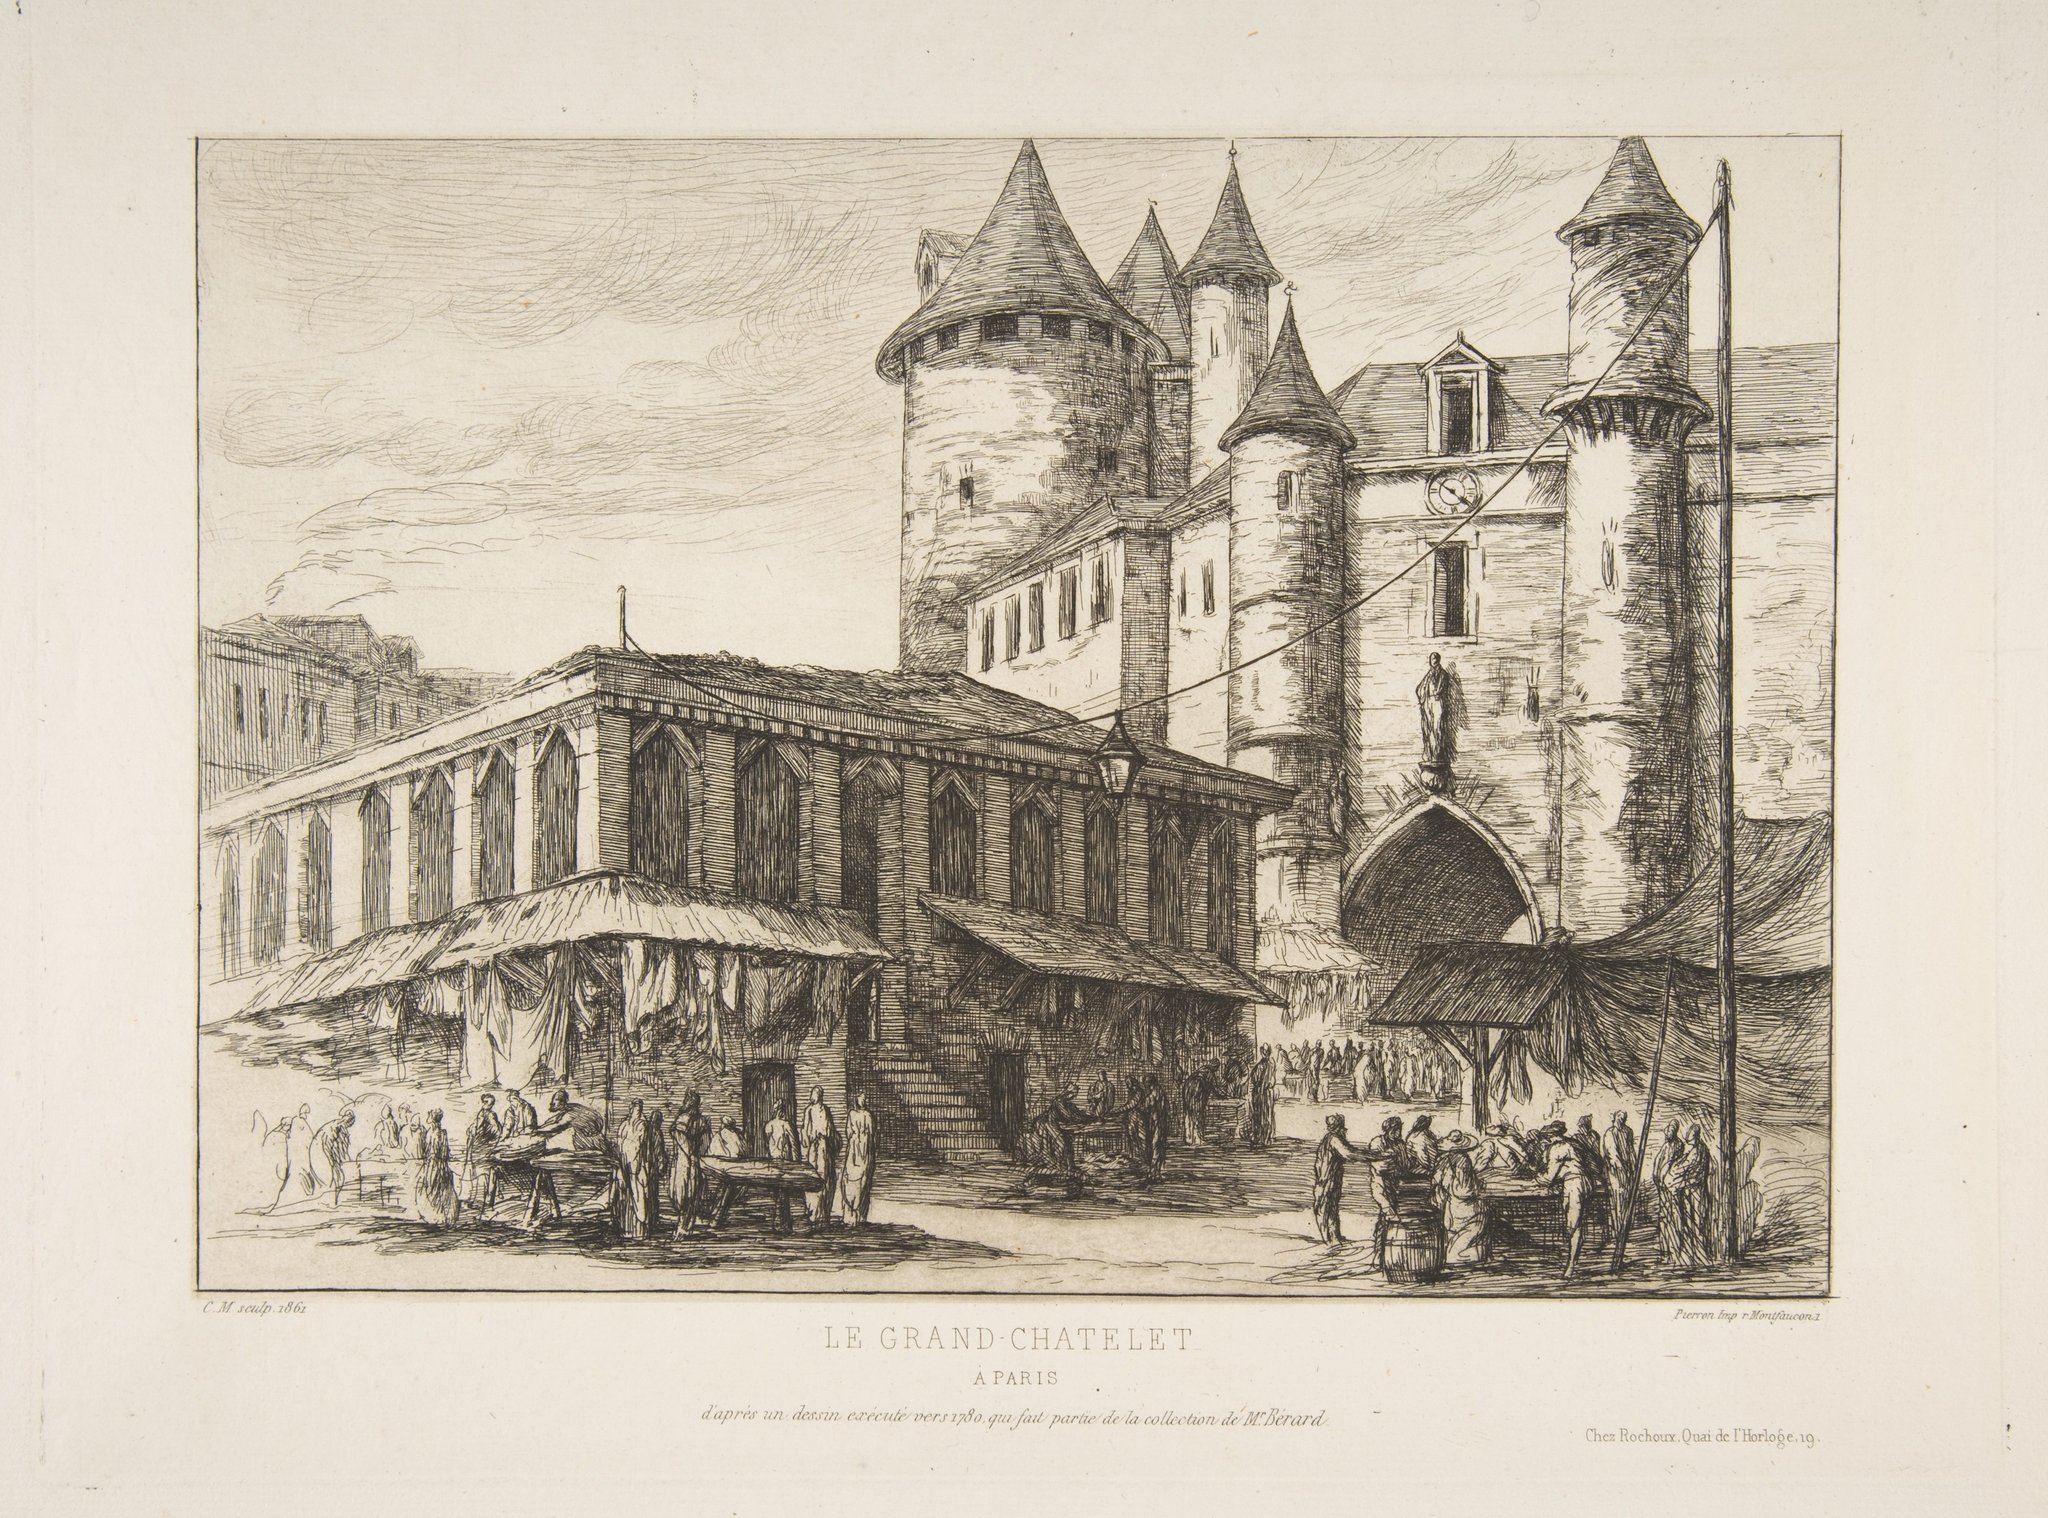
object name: print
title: Le Grand Châtelet (Grand Châtelet, Paris circa 1780)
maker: charles meryon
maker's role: artist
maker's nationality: french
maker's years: 1821-1868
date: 1861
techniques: drypoint, etching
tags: buildings,paris